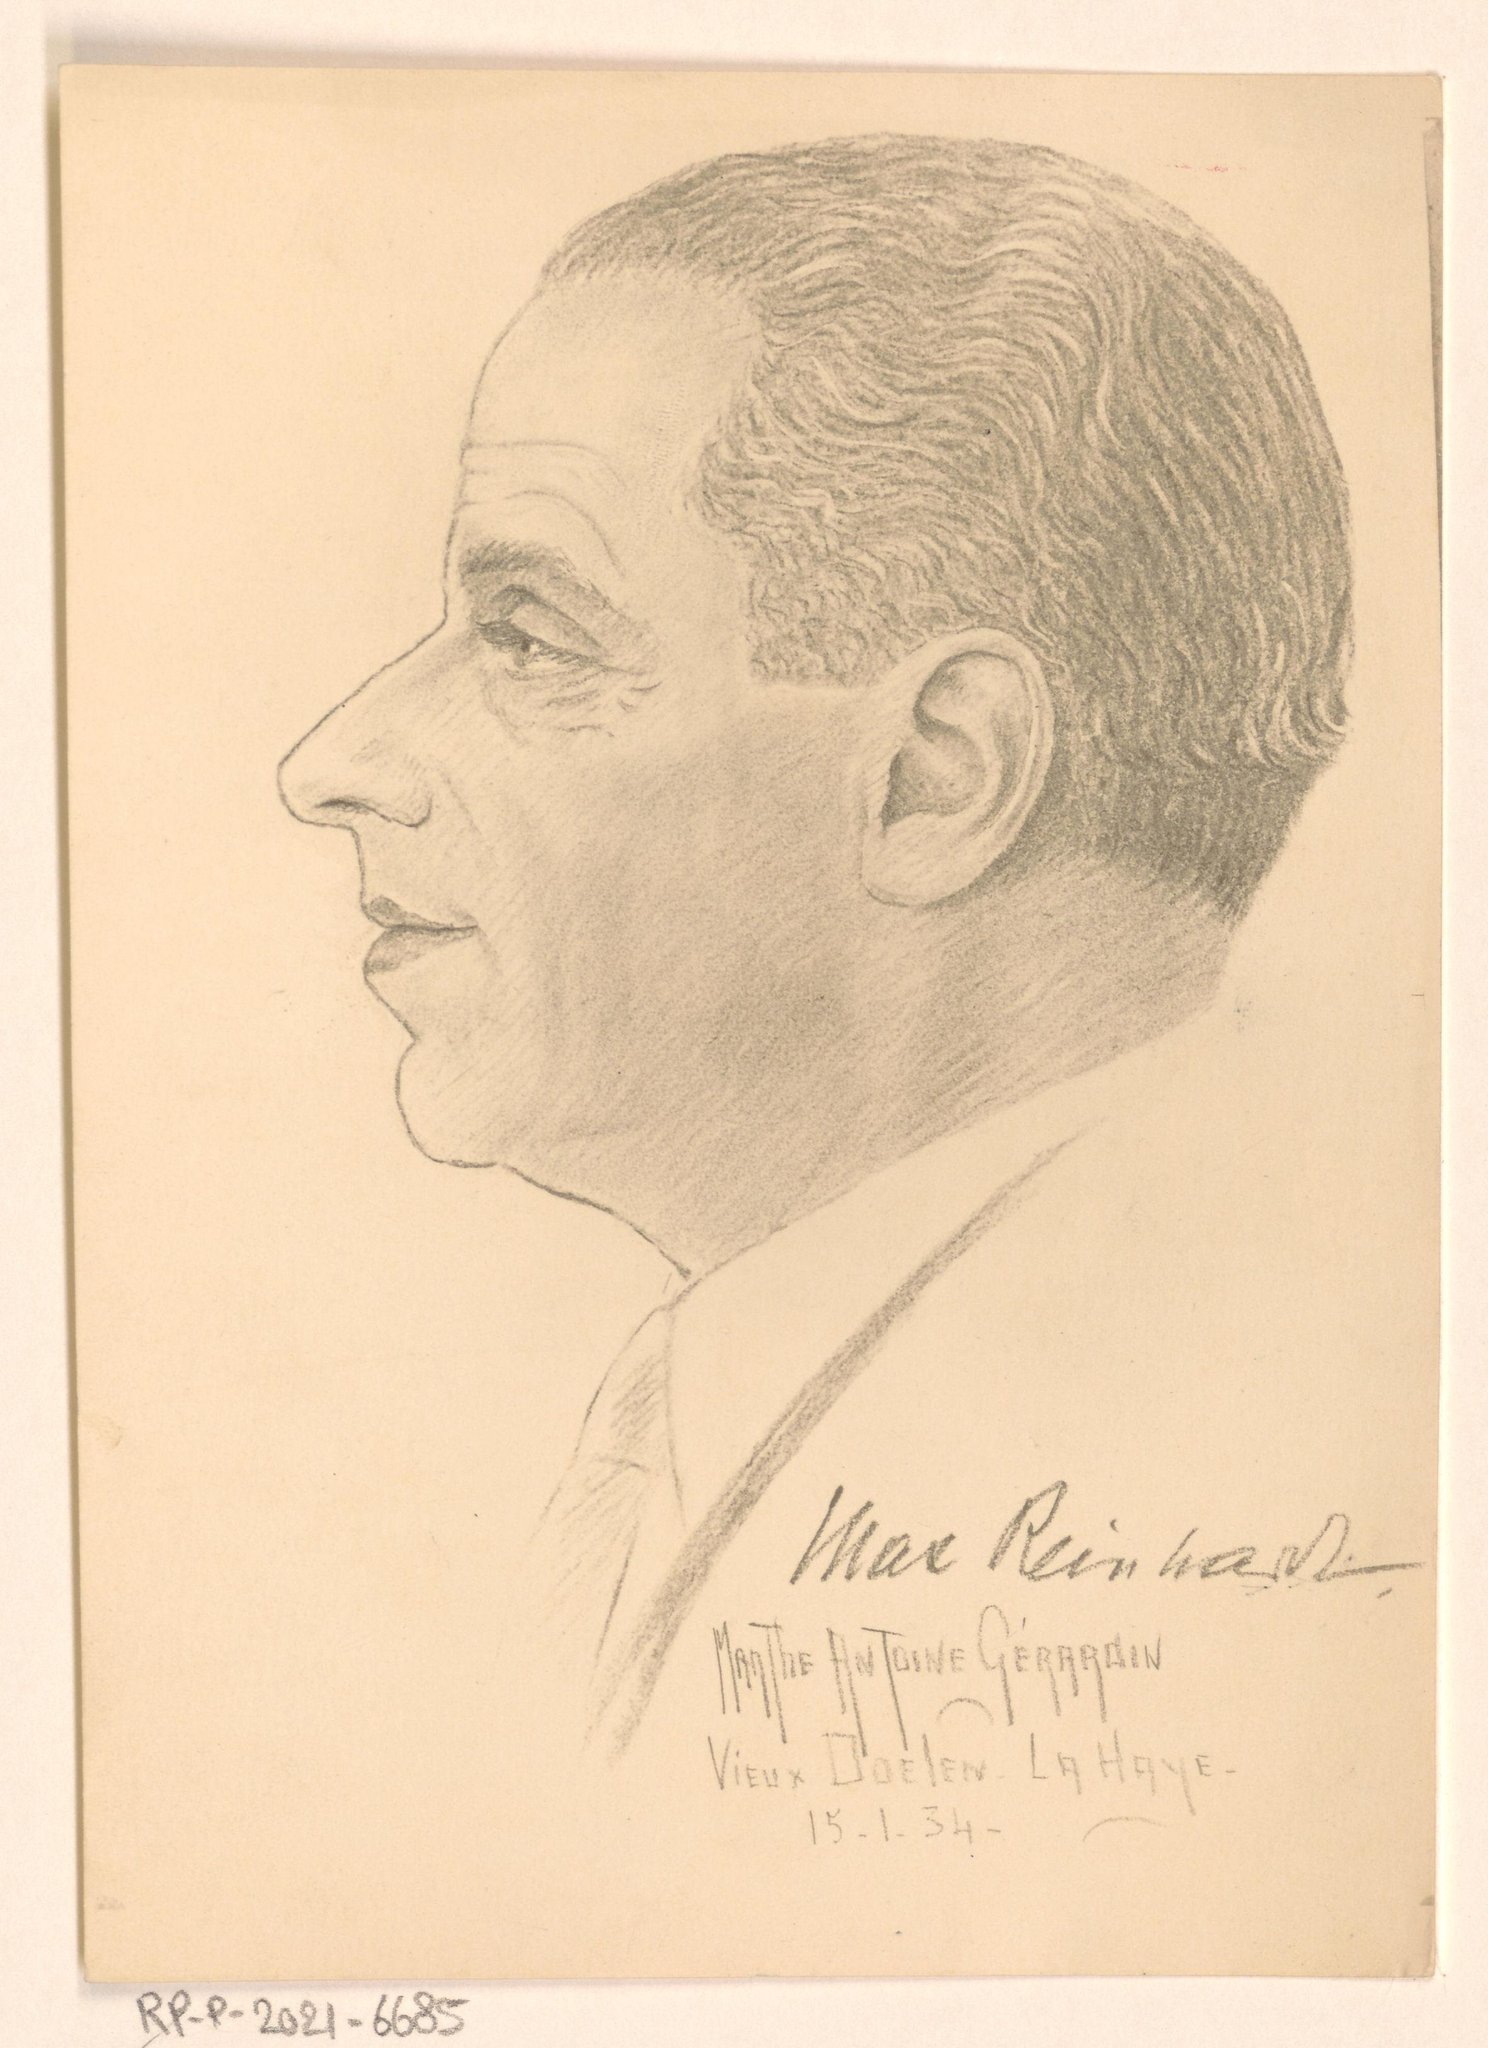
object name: print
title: Portret van Max Reinhardt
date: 1934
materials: paper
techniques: lithograph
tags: new york (city), historical persons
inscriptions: date